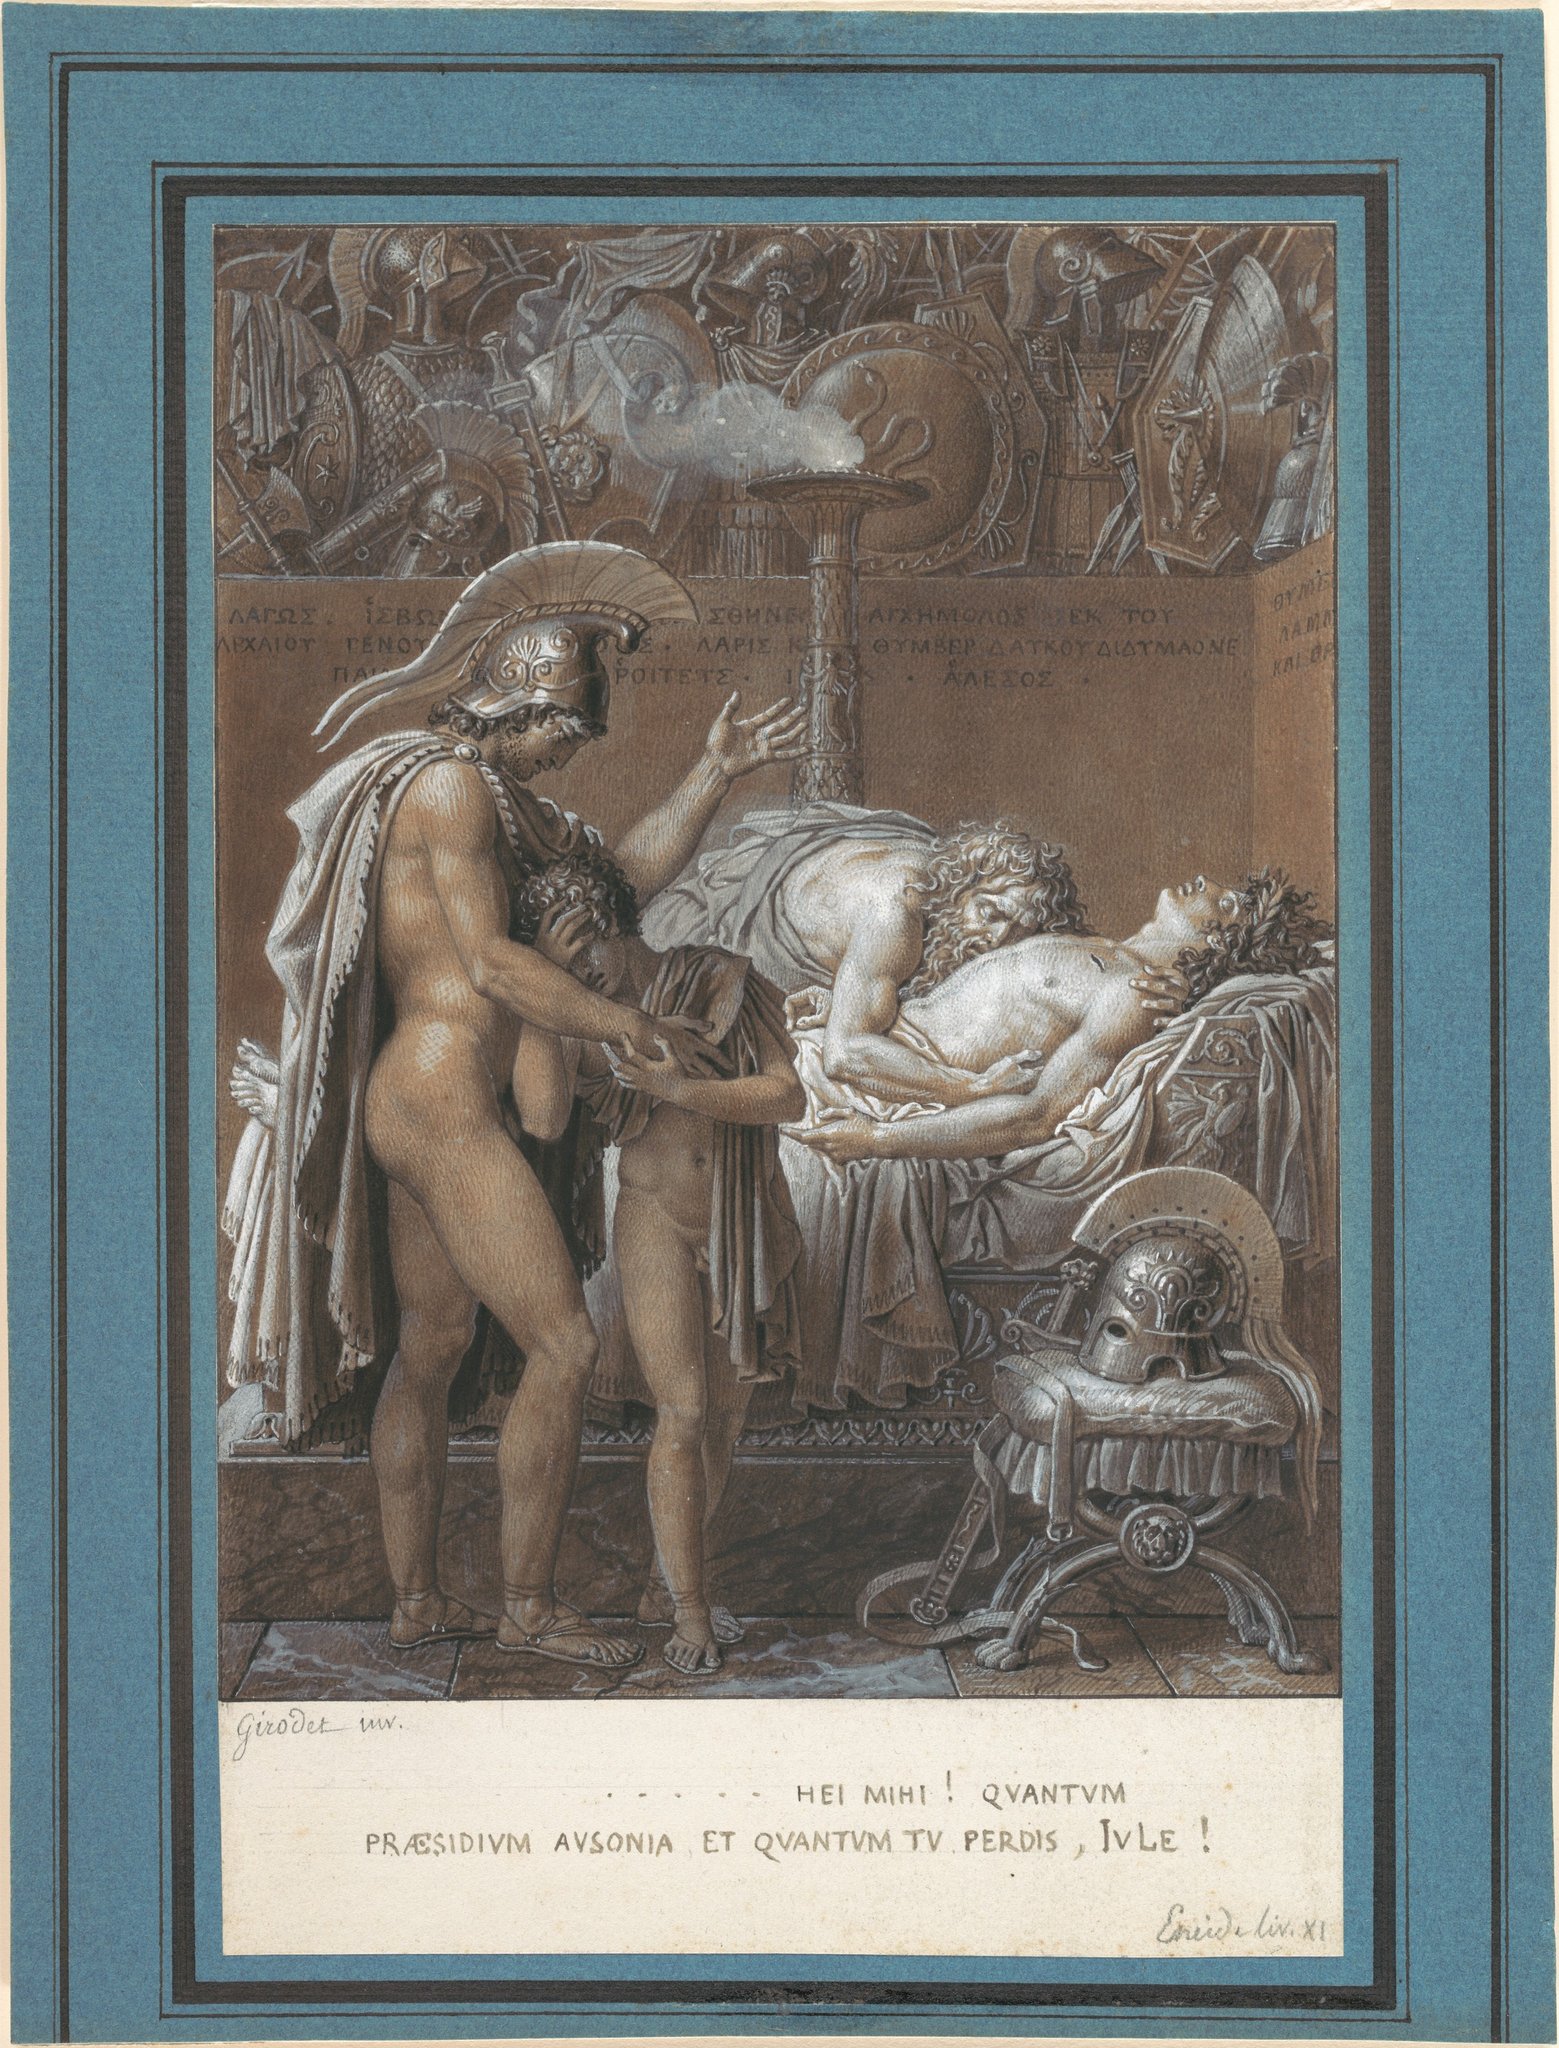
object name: drawing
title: The Mourning of Pallas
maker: anne louis girodet-trioson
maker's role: artist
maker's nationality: french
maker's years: 1767-1824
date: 1790-1793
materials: ink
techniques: brush, heightening, pen, wash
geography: france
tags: armor,sadness,boys,men,male nudes,aeneas,death,aeneid